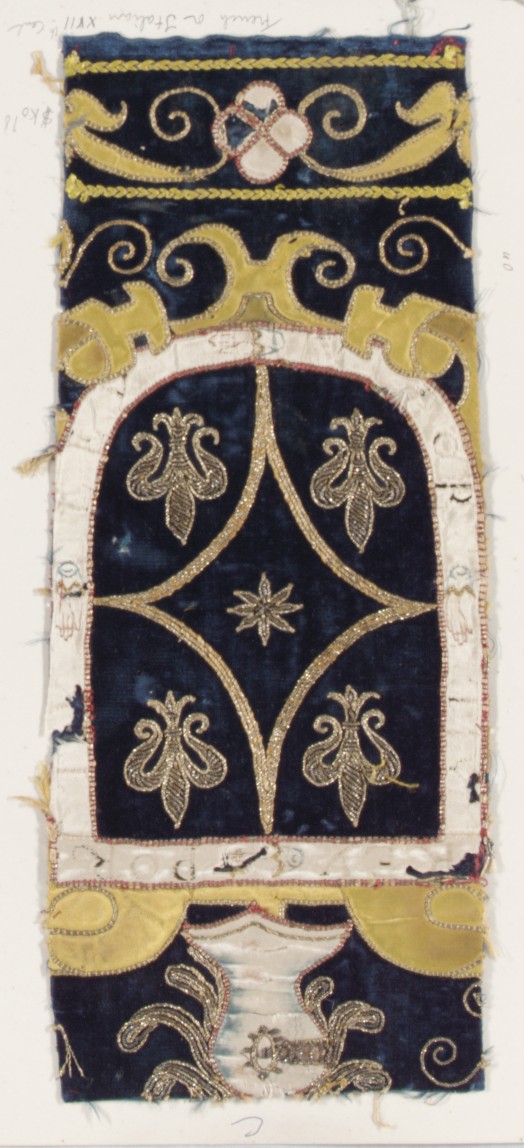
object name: fragment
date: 1601-1700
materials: metal thread, silk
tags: flowers